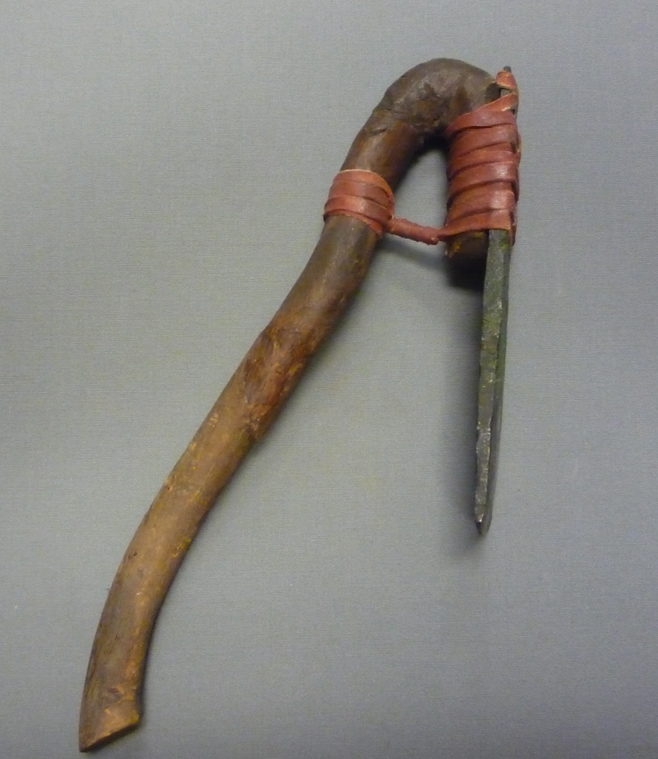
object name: adze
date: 1550-1295 BCE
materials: bronze, copper alloy, leather, wood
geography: egypt